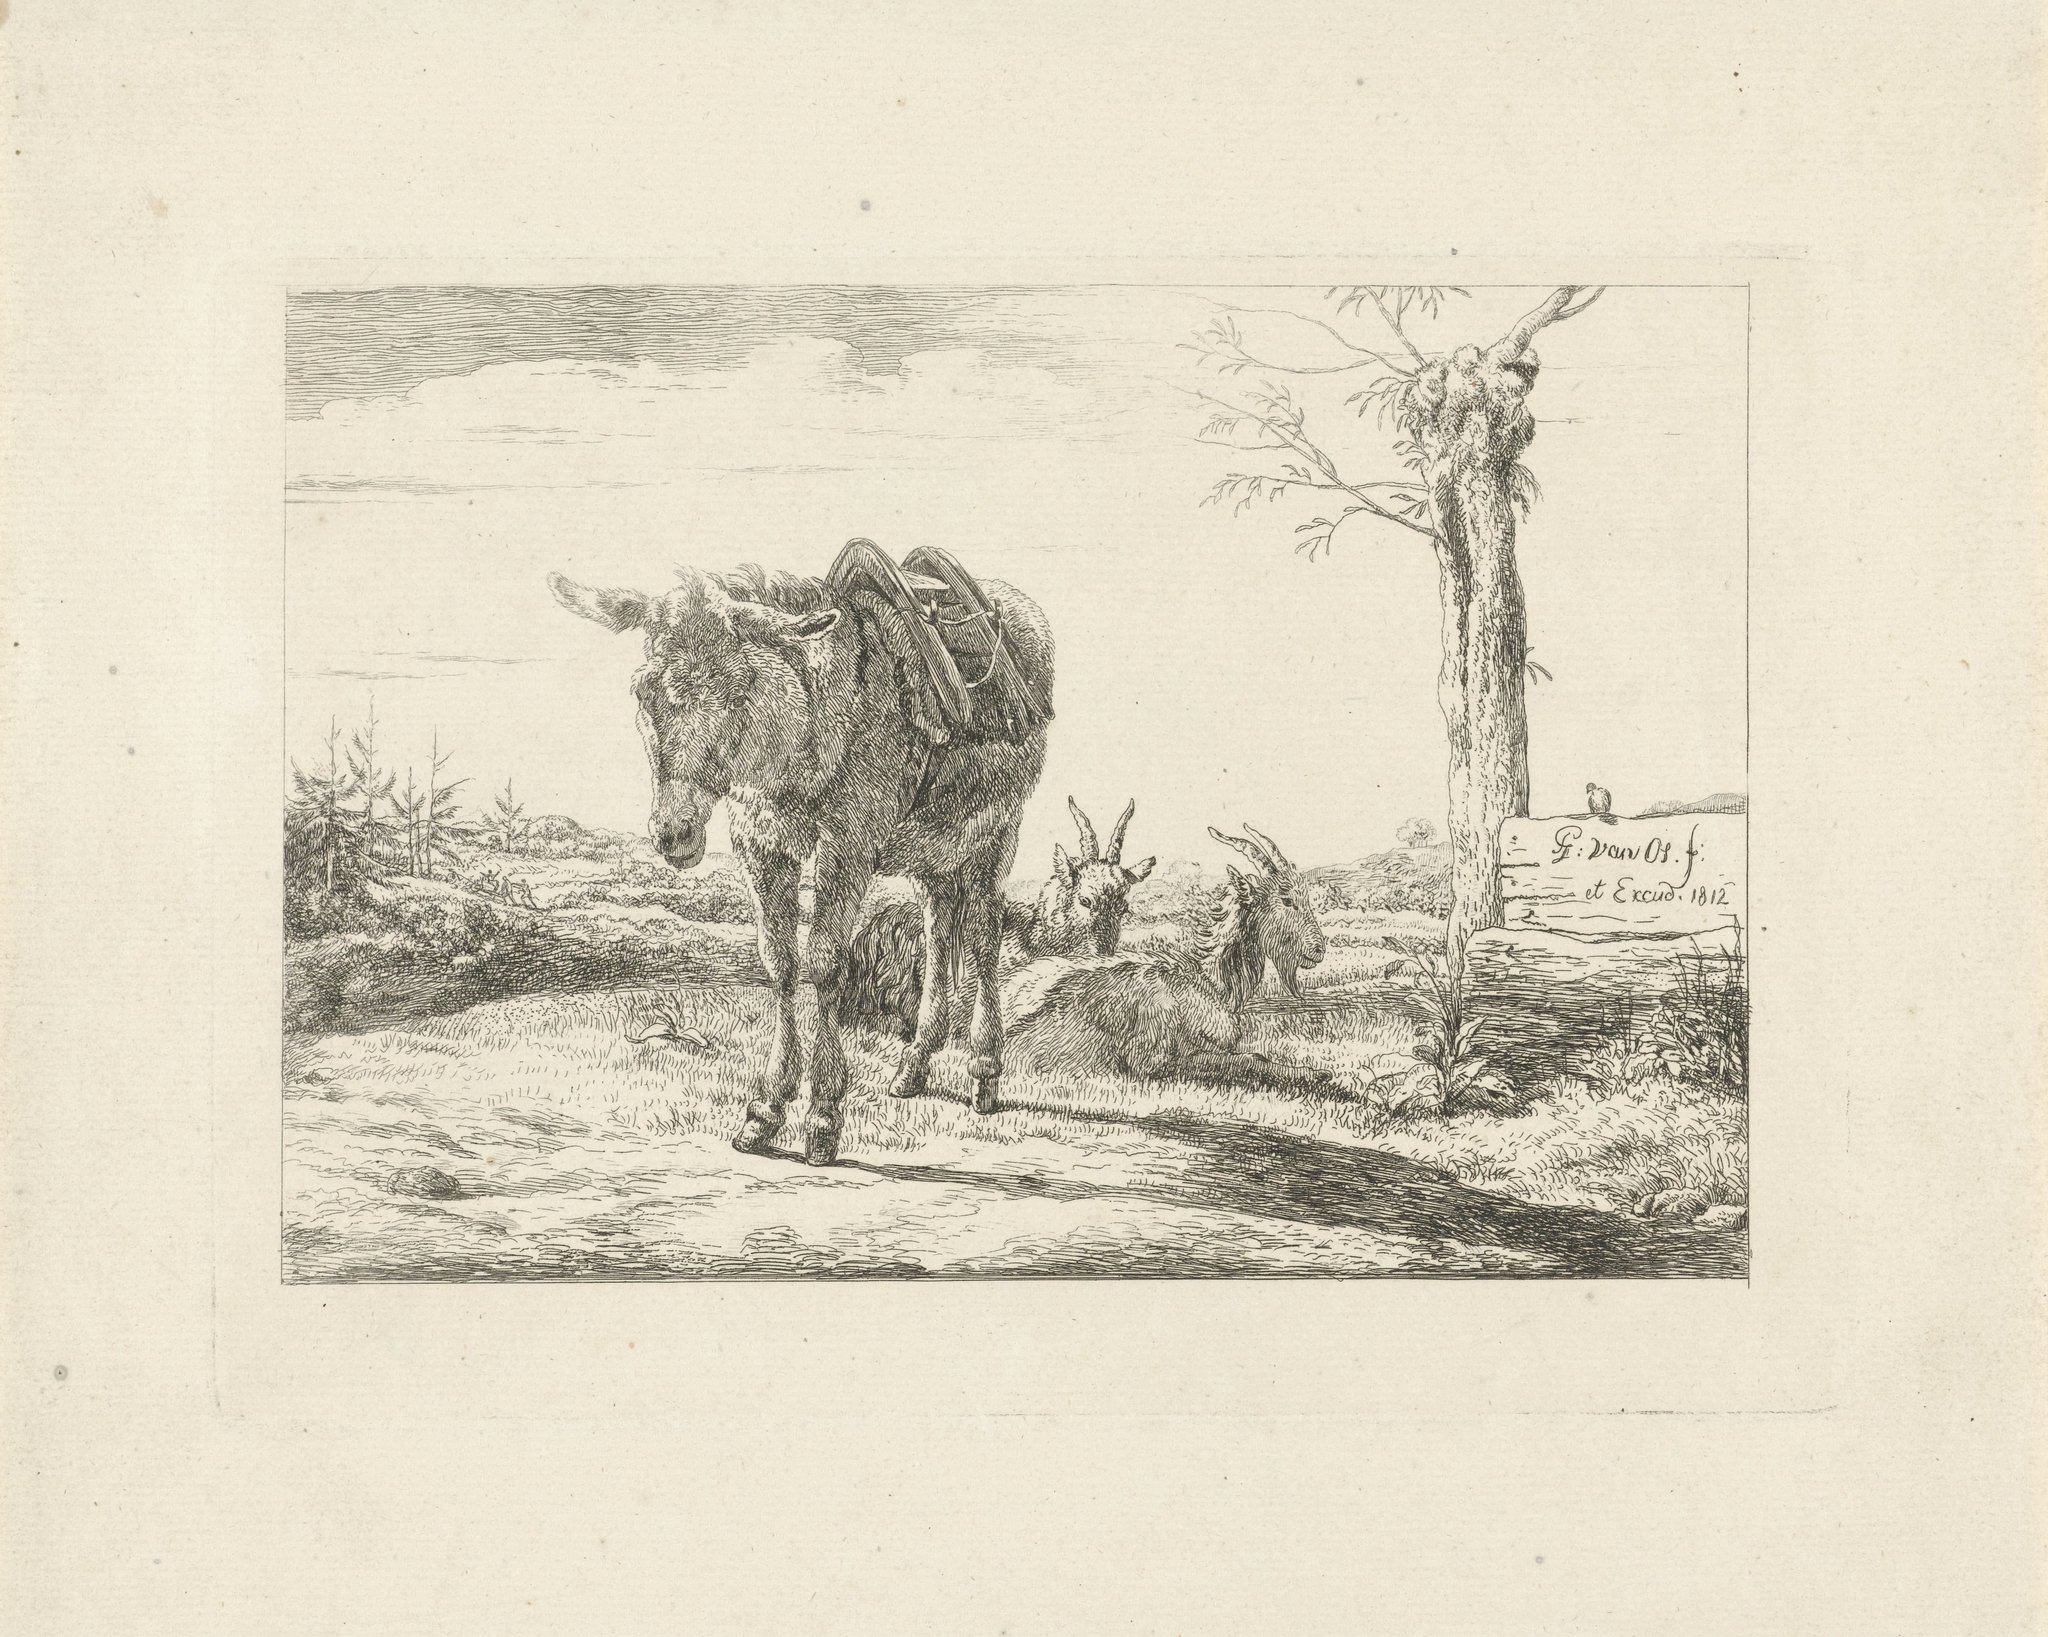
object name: print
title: Een ezel en twee geiten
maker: pieter gerardus van os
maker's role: draughtsman, painter, print maker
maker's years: 1776-1839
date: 1812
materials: paper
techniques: etching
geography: netherlands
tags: ass, donkey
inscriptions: collector's mark: Lugt 2760, collector's mark: Lugt 2228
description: Waarschijnlijk titelprent voor een serie uit 1812. Het is echter onduidelijk welke prenten bij deze serie horen, zie Kramm.